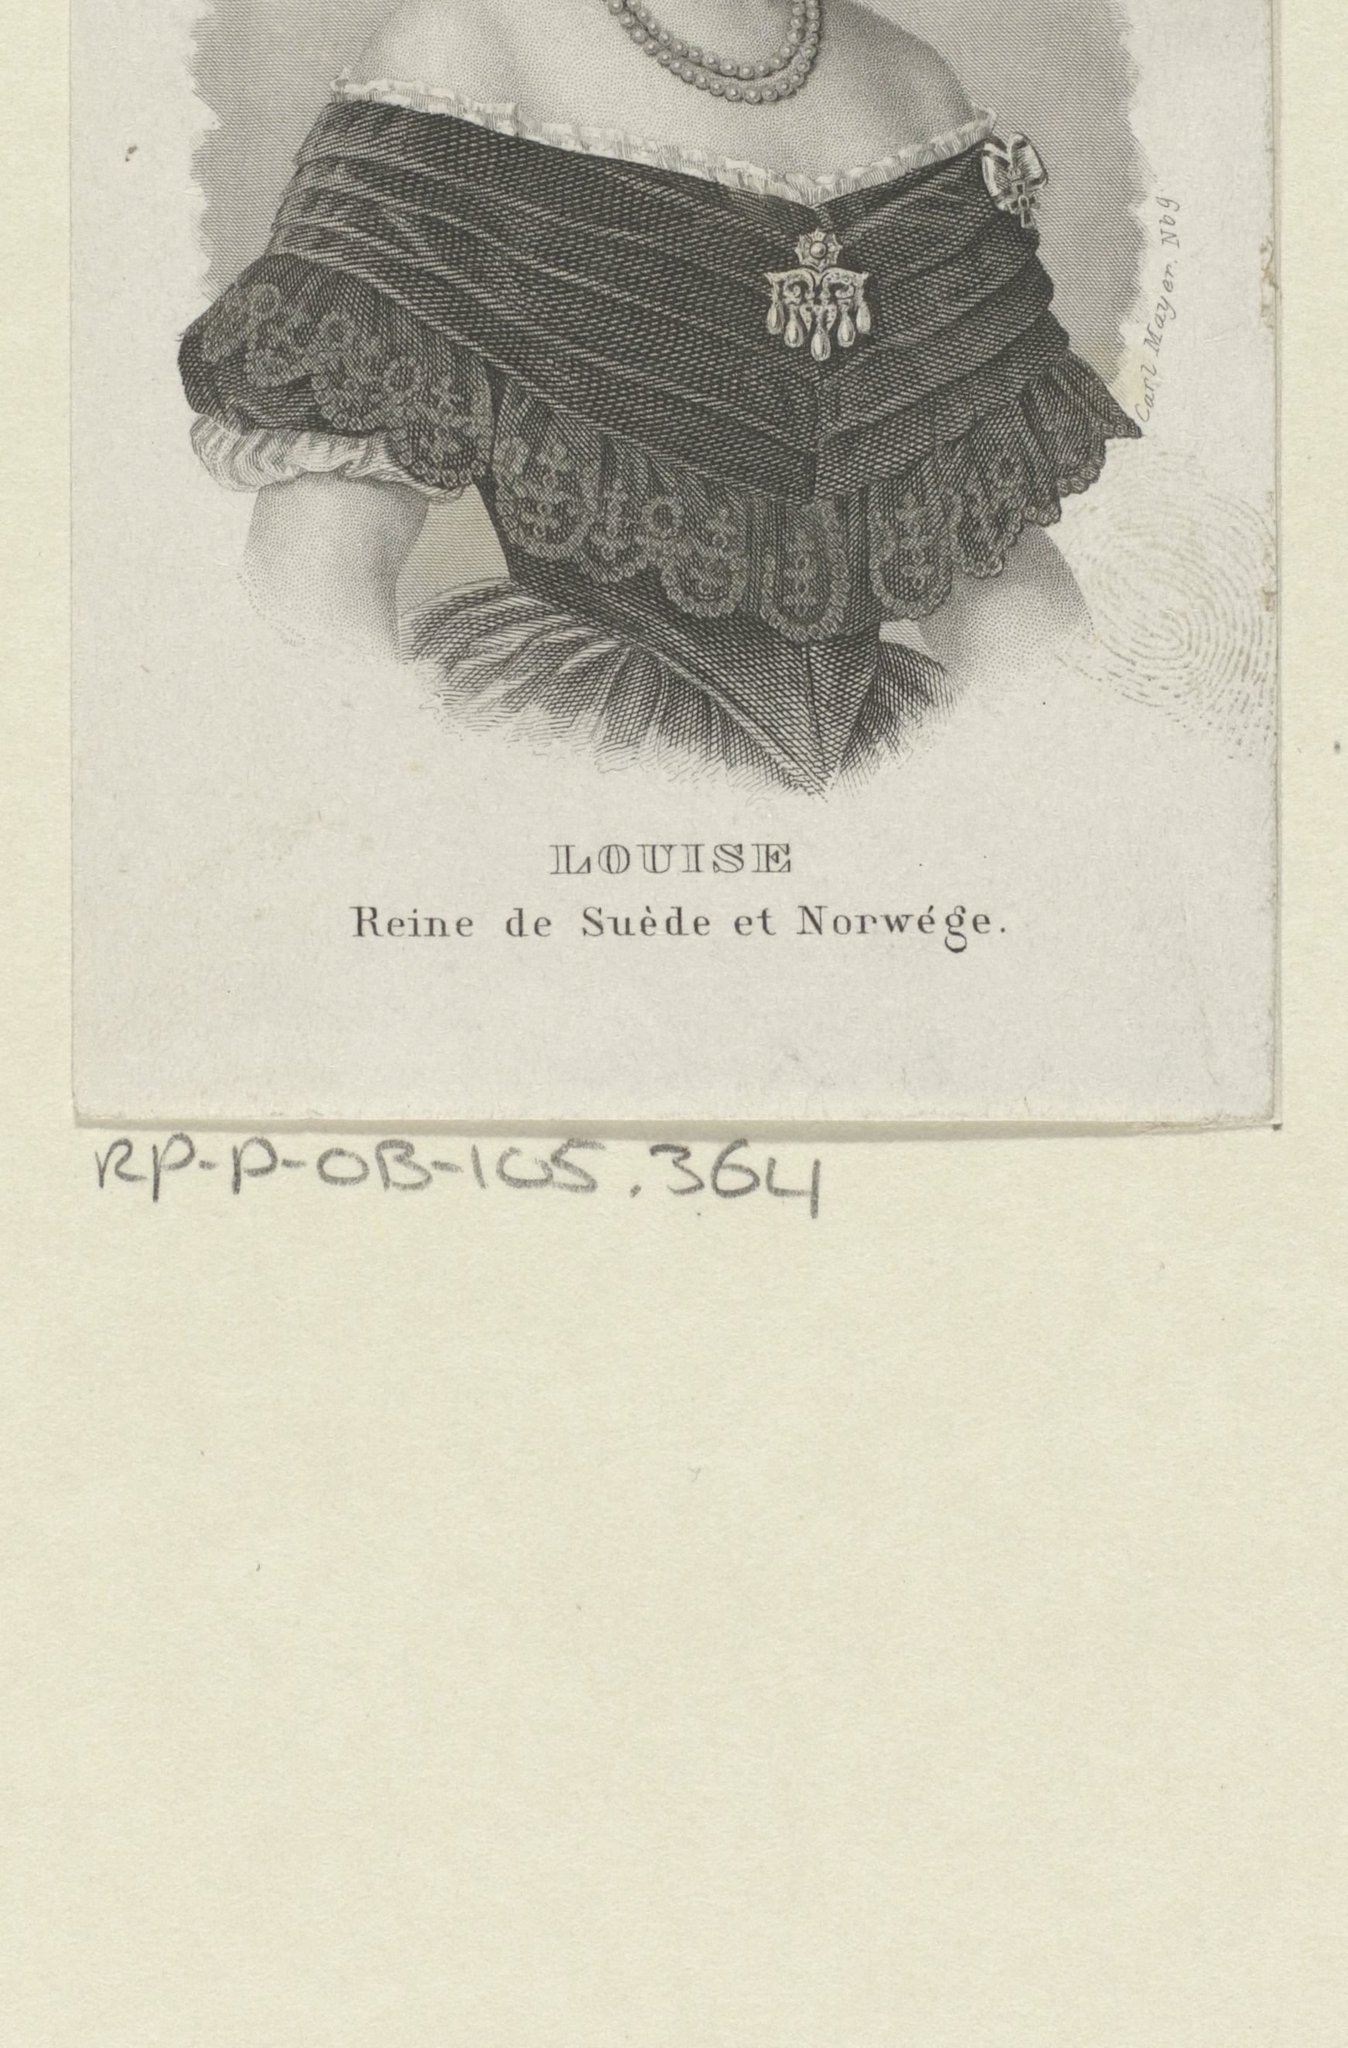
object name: print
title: Portret van Louise, prinses der Nederlanden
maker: carl mayer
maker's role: print maker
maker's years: 1798-1868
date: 1850-1868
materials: paper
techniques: engraving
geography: nuremberg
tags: the hague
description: De hier vermelde titel verwijst naar de hoogst verkregen titel van de geportretteerde, niet per se naar de titel die de geportretteerde op deze voorstelling draagt.